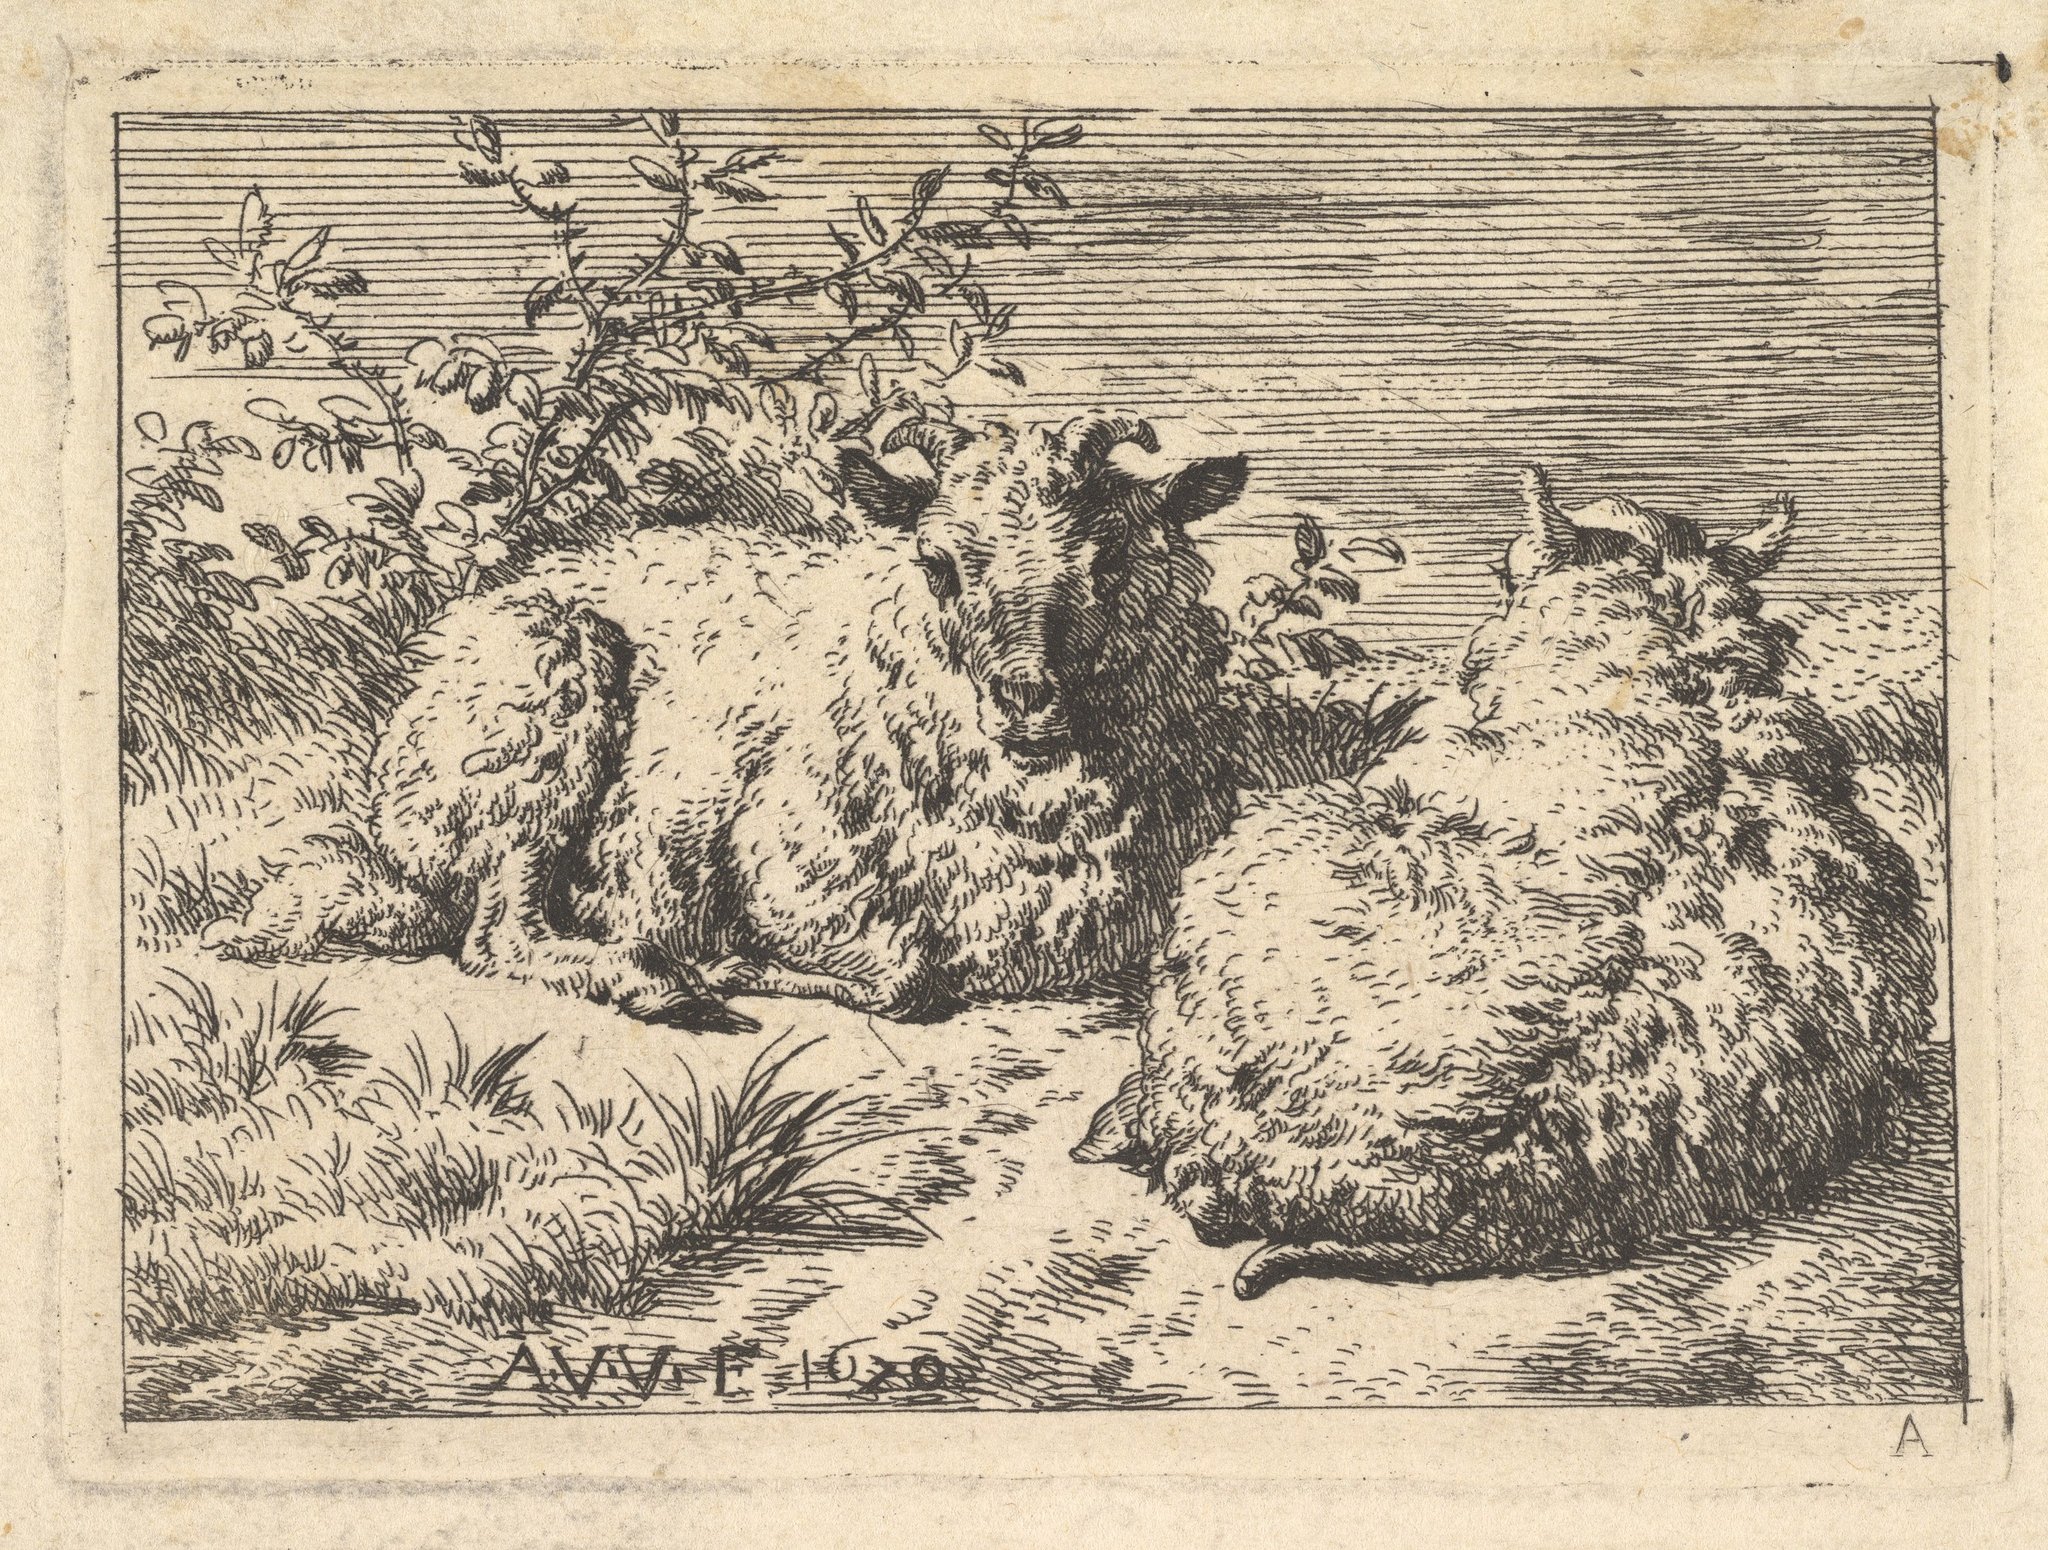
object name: print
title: Two Recumbent Sheep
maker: adriaen van de velde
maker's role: artist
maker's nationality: dutch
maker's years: 1636-1672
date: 1670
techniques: etching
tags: sheep,plants